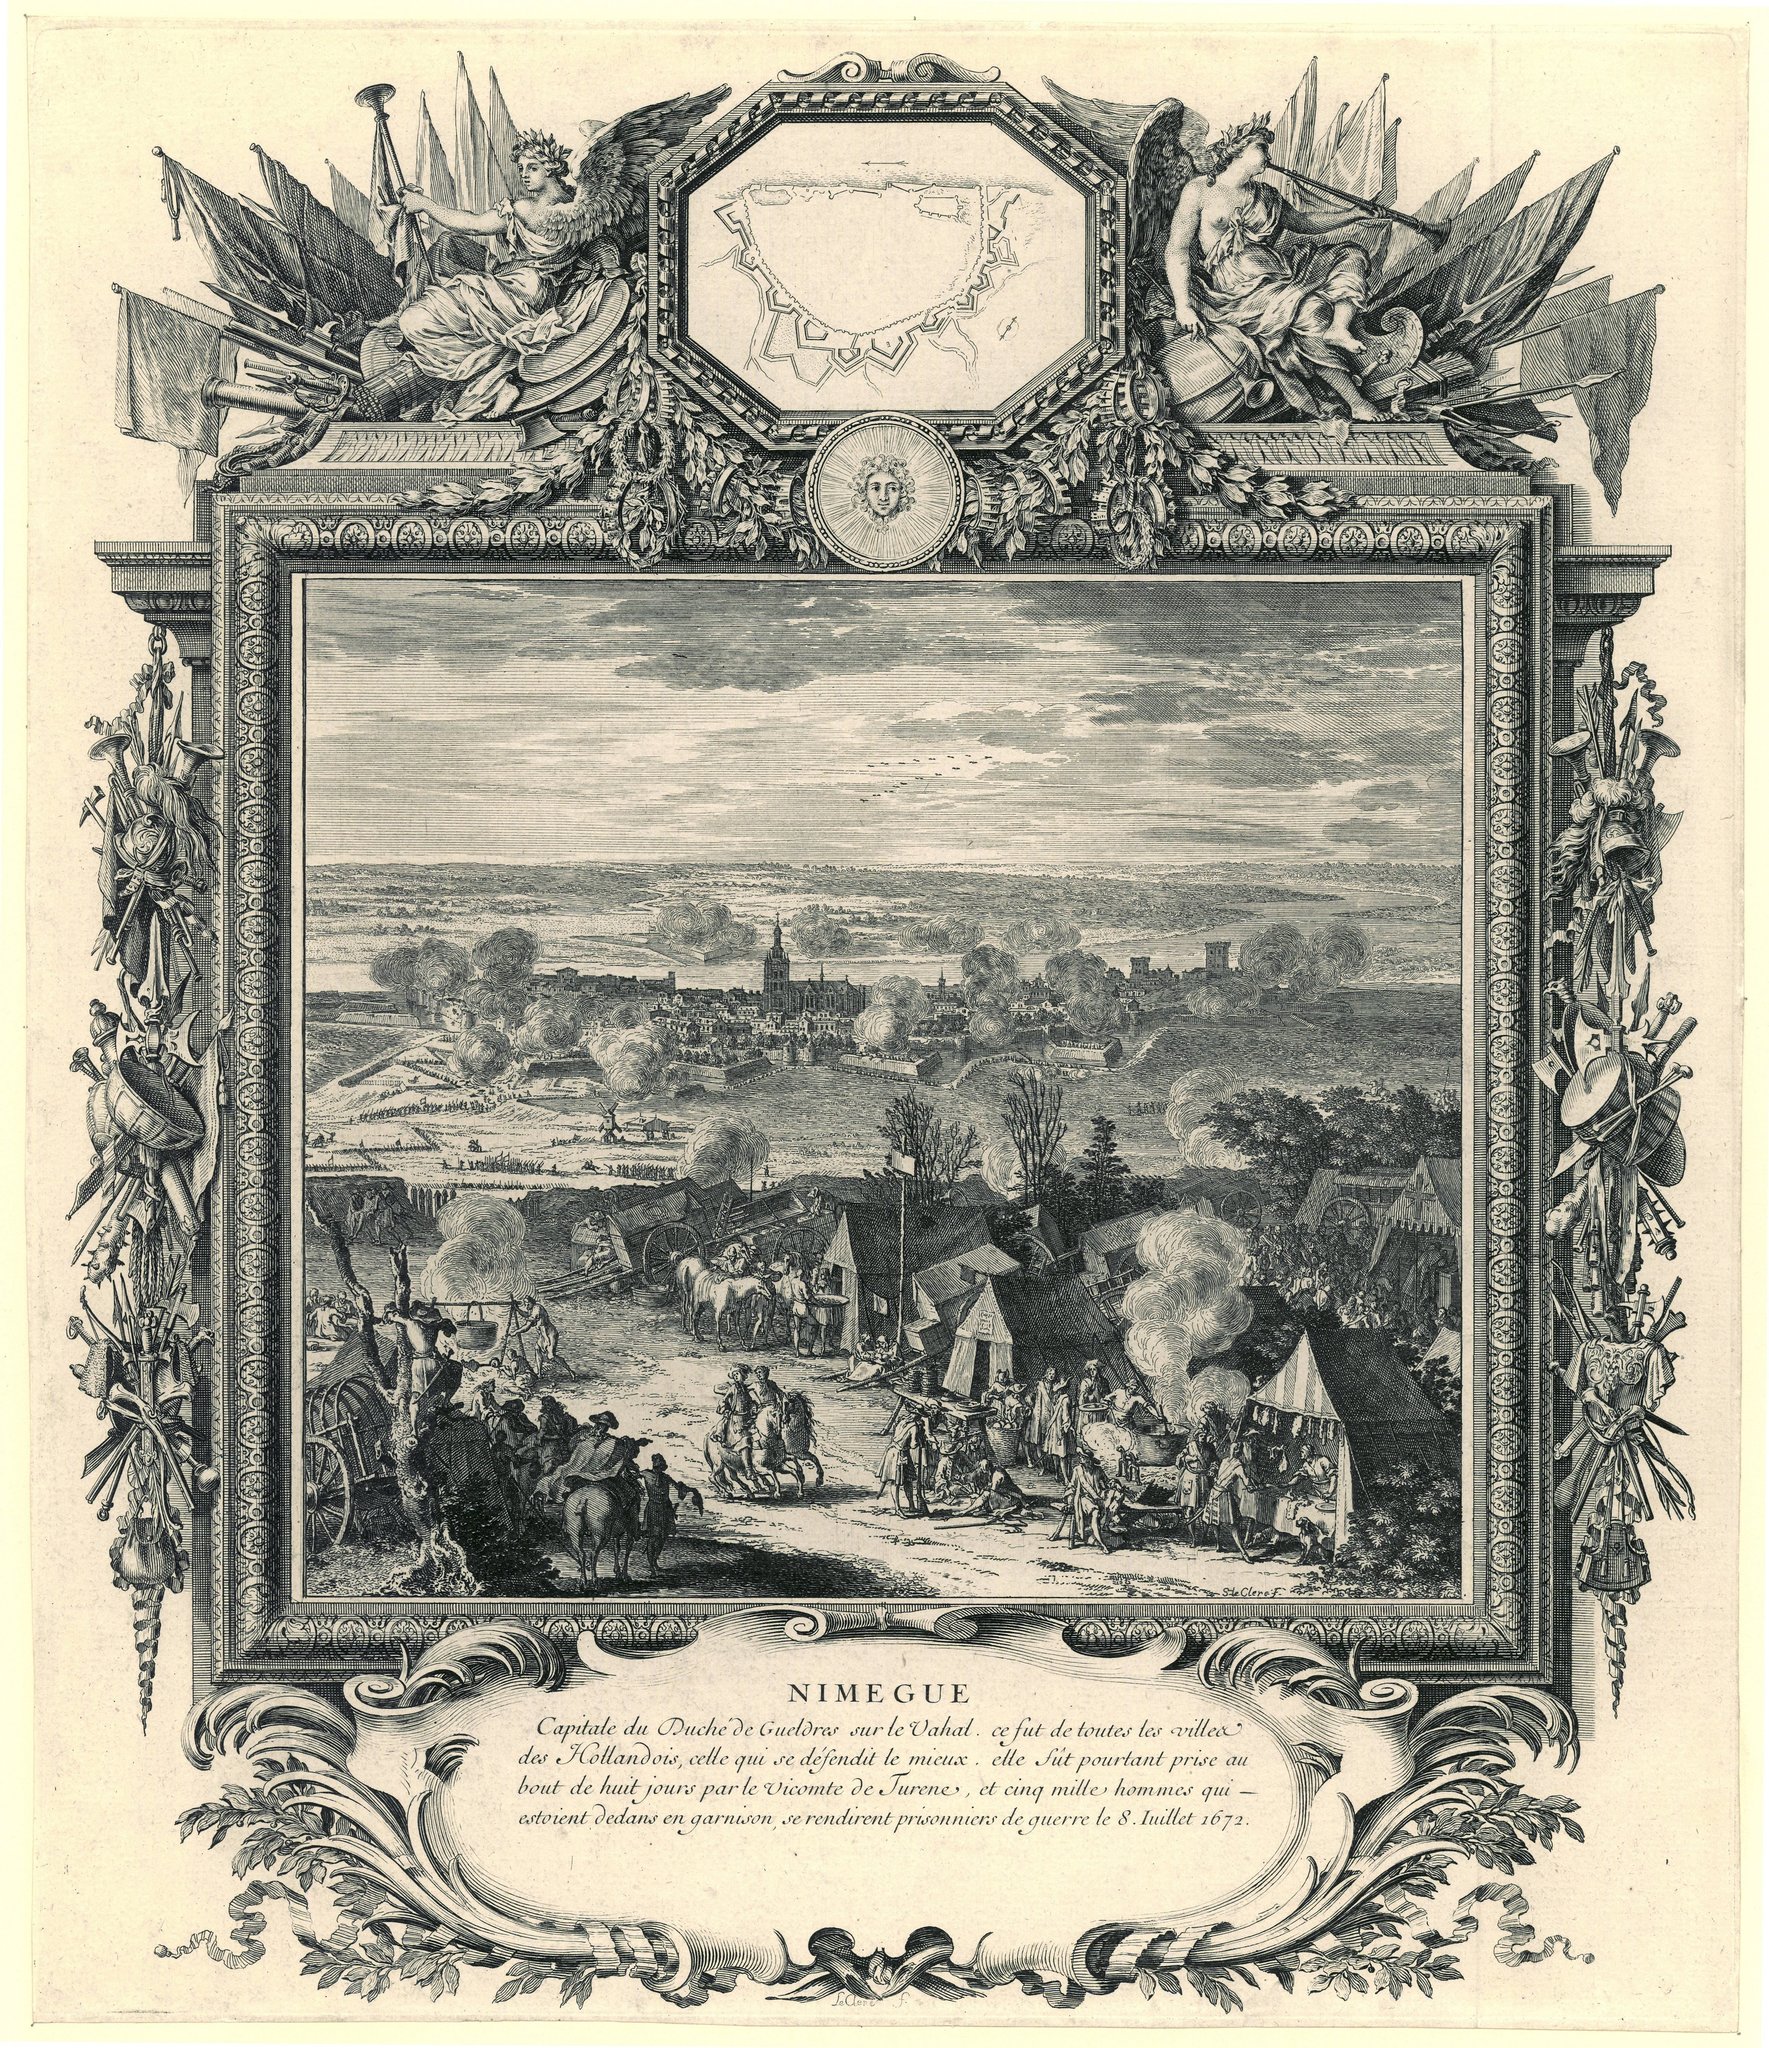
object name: history print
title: Verovering van Nijmegen door de Franse legers op 8 juli 1672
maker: sébastien leclerc (i)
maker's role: print maker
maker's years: 1637-1714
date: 1683-1694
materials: paper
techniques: engraving, etching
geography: france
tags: lodewijk xiv (koning van frankrijk), capture of city (after the siege), nijmegen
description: De verovering van Nijmegen na een belegering van acht dagen door het Franse leger onder Turenne op 8 juli 1672. De prent maakt deel uit van een Franse reeks van 28 prenten met de veroveringen van de Franse koning Lodewijk XIV tussen 1672 en 1678 getiteld: Grandes Conquêtes du Roi. In een ornamentele omlijsting met bovenaan een plattegrond van de versterkingen van de stad, verder trofeeën van wapens en delen van wapenrustingen. Onderaan een cartouche met opschrift van vier regels in het Frans.